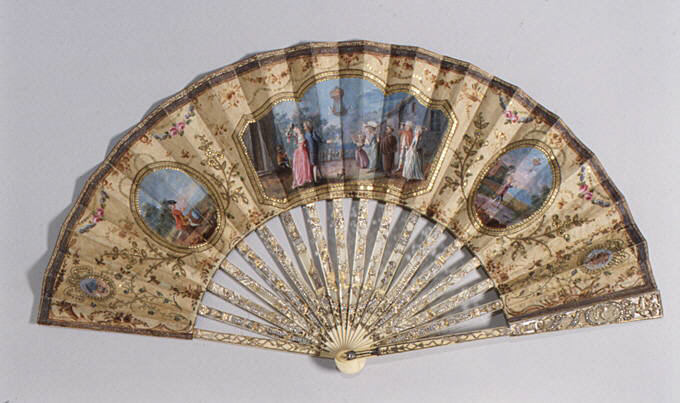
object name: fan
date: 1785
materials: glass, gold thread, ivory, parchment, silk, silver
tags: men,women